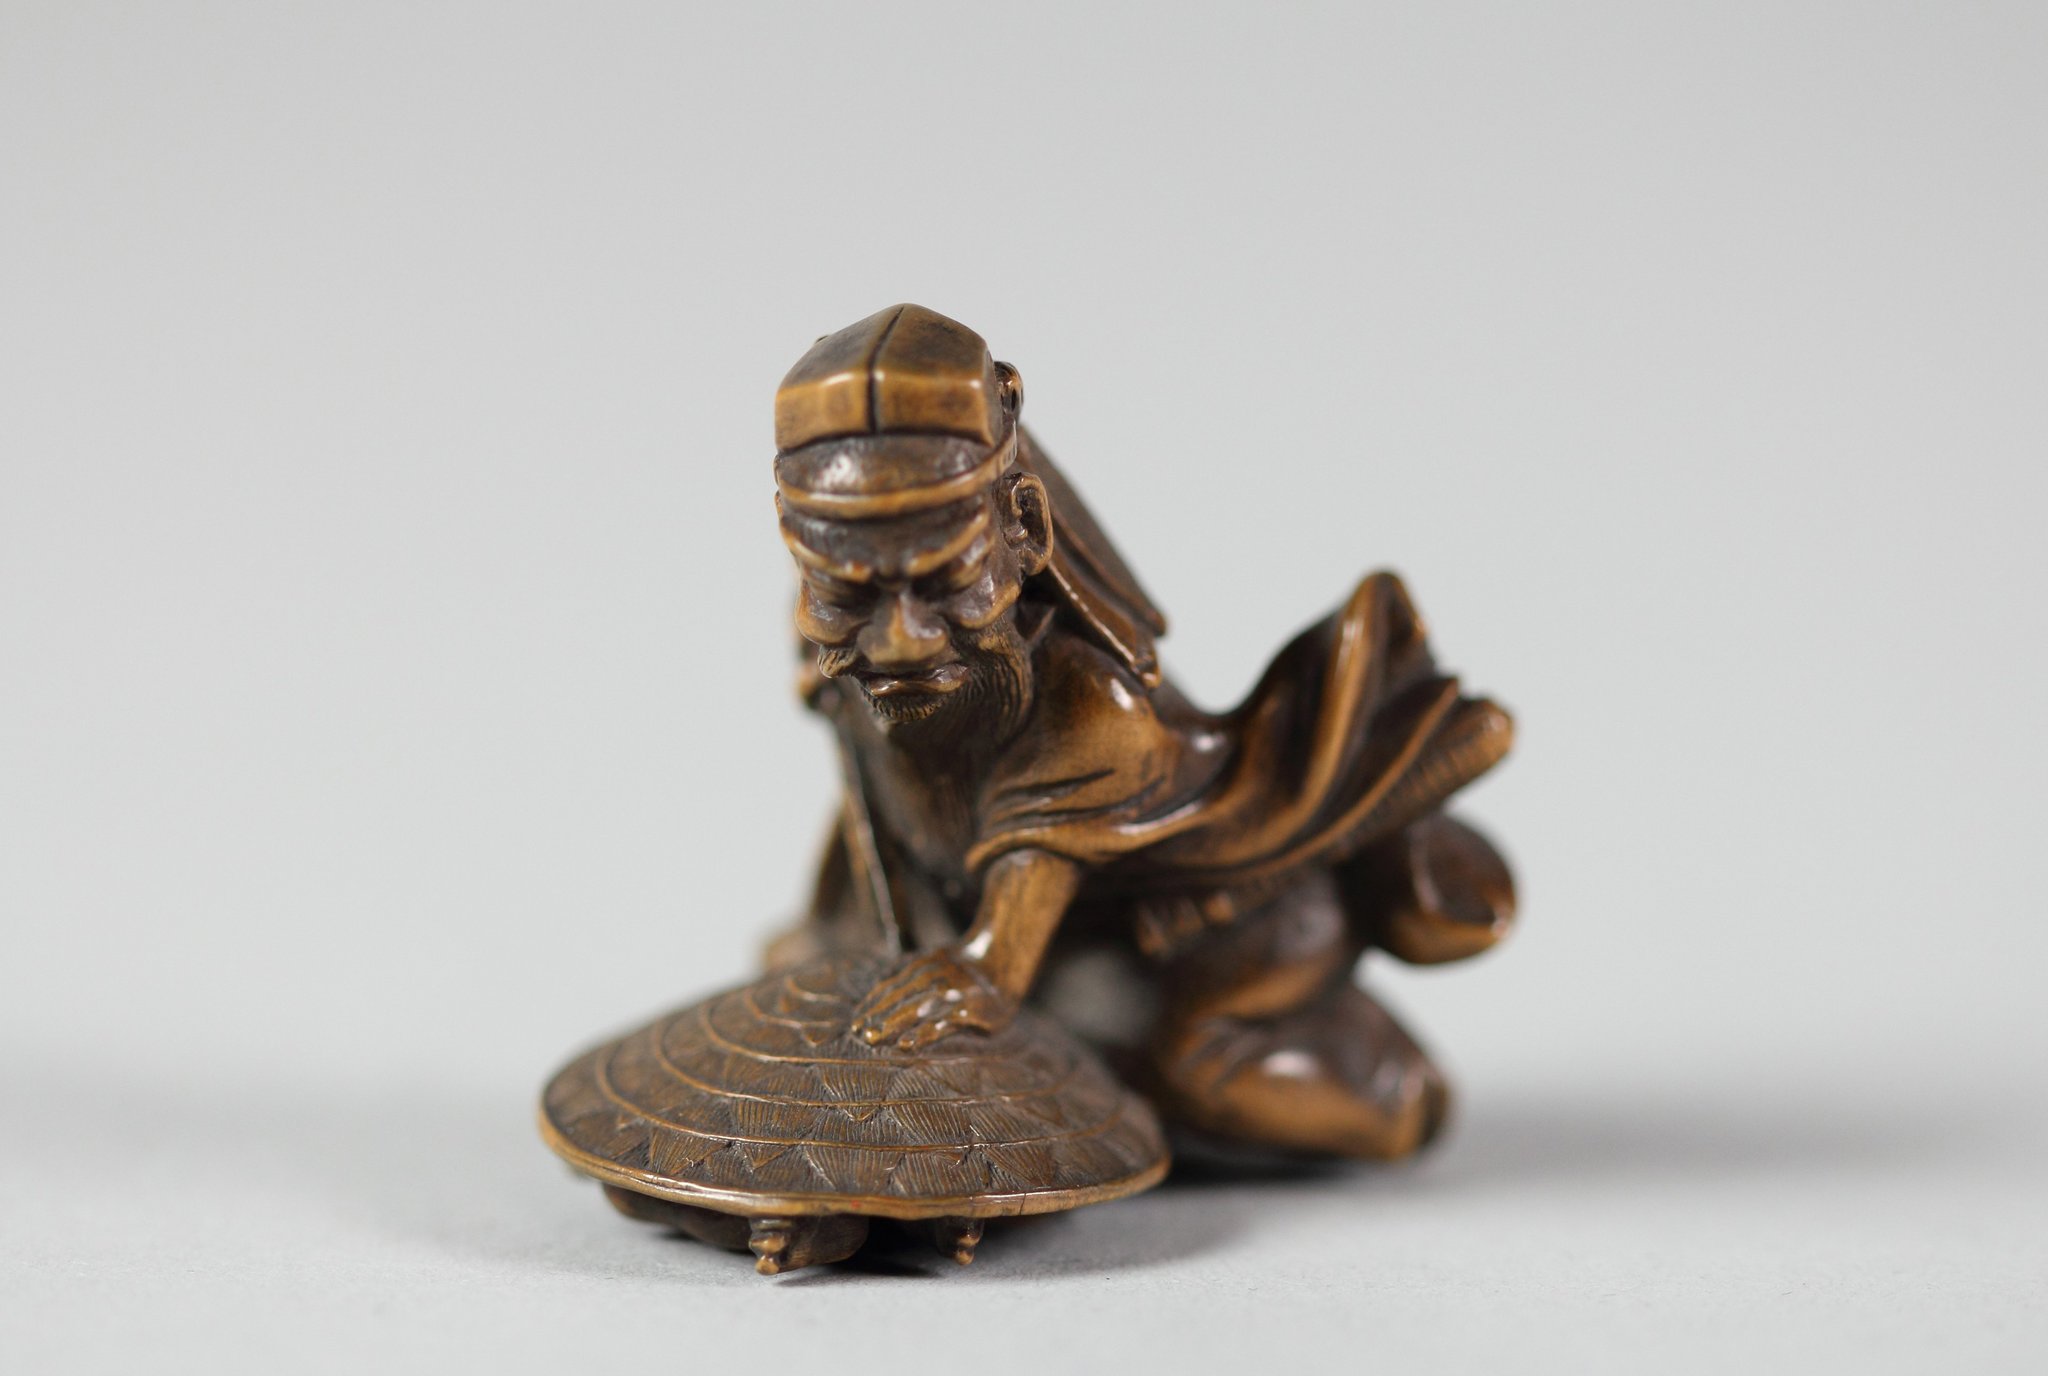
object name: netsuke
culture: japanese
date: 1801-1900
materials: wood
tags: men